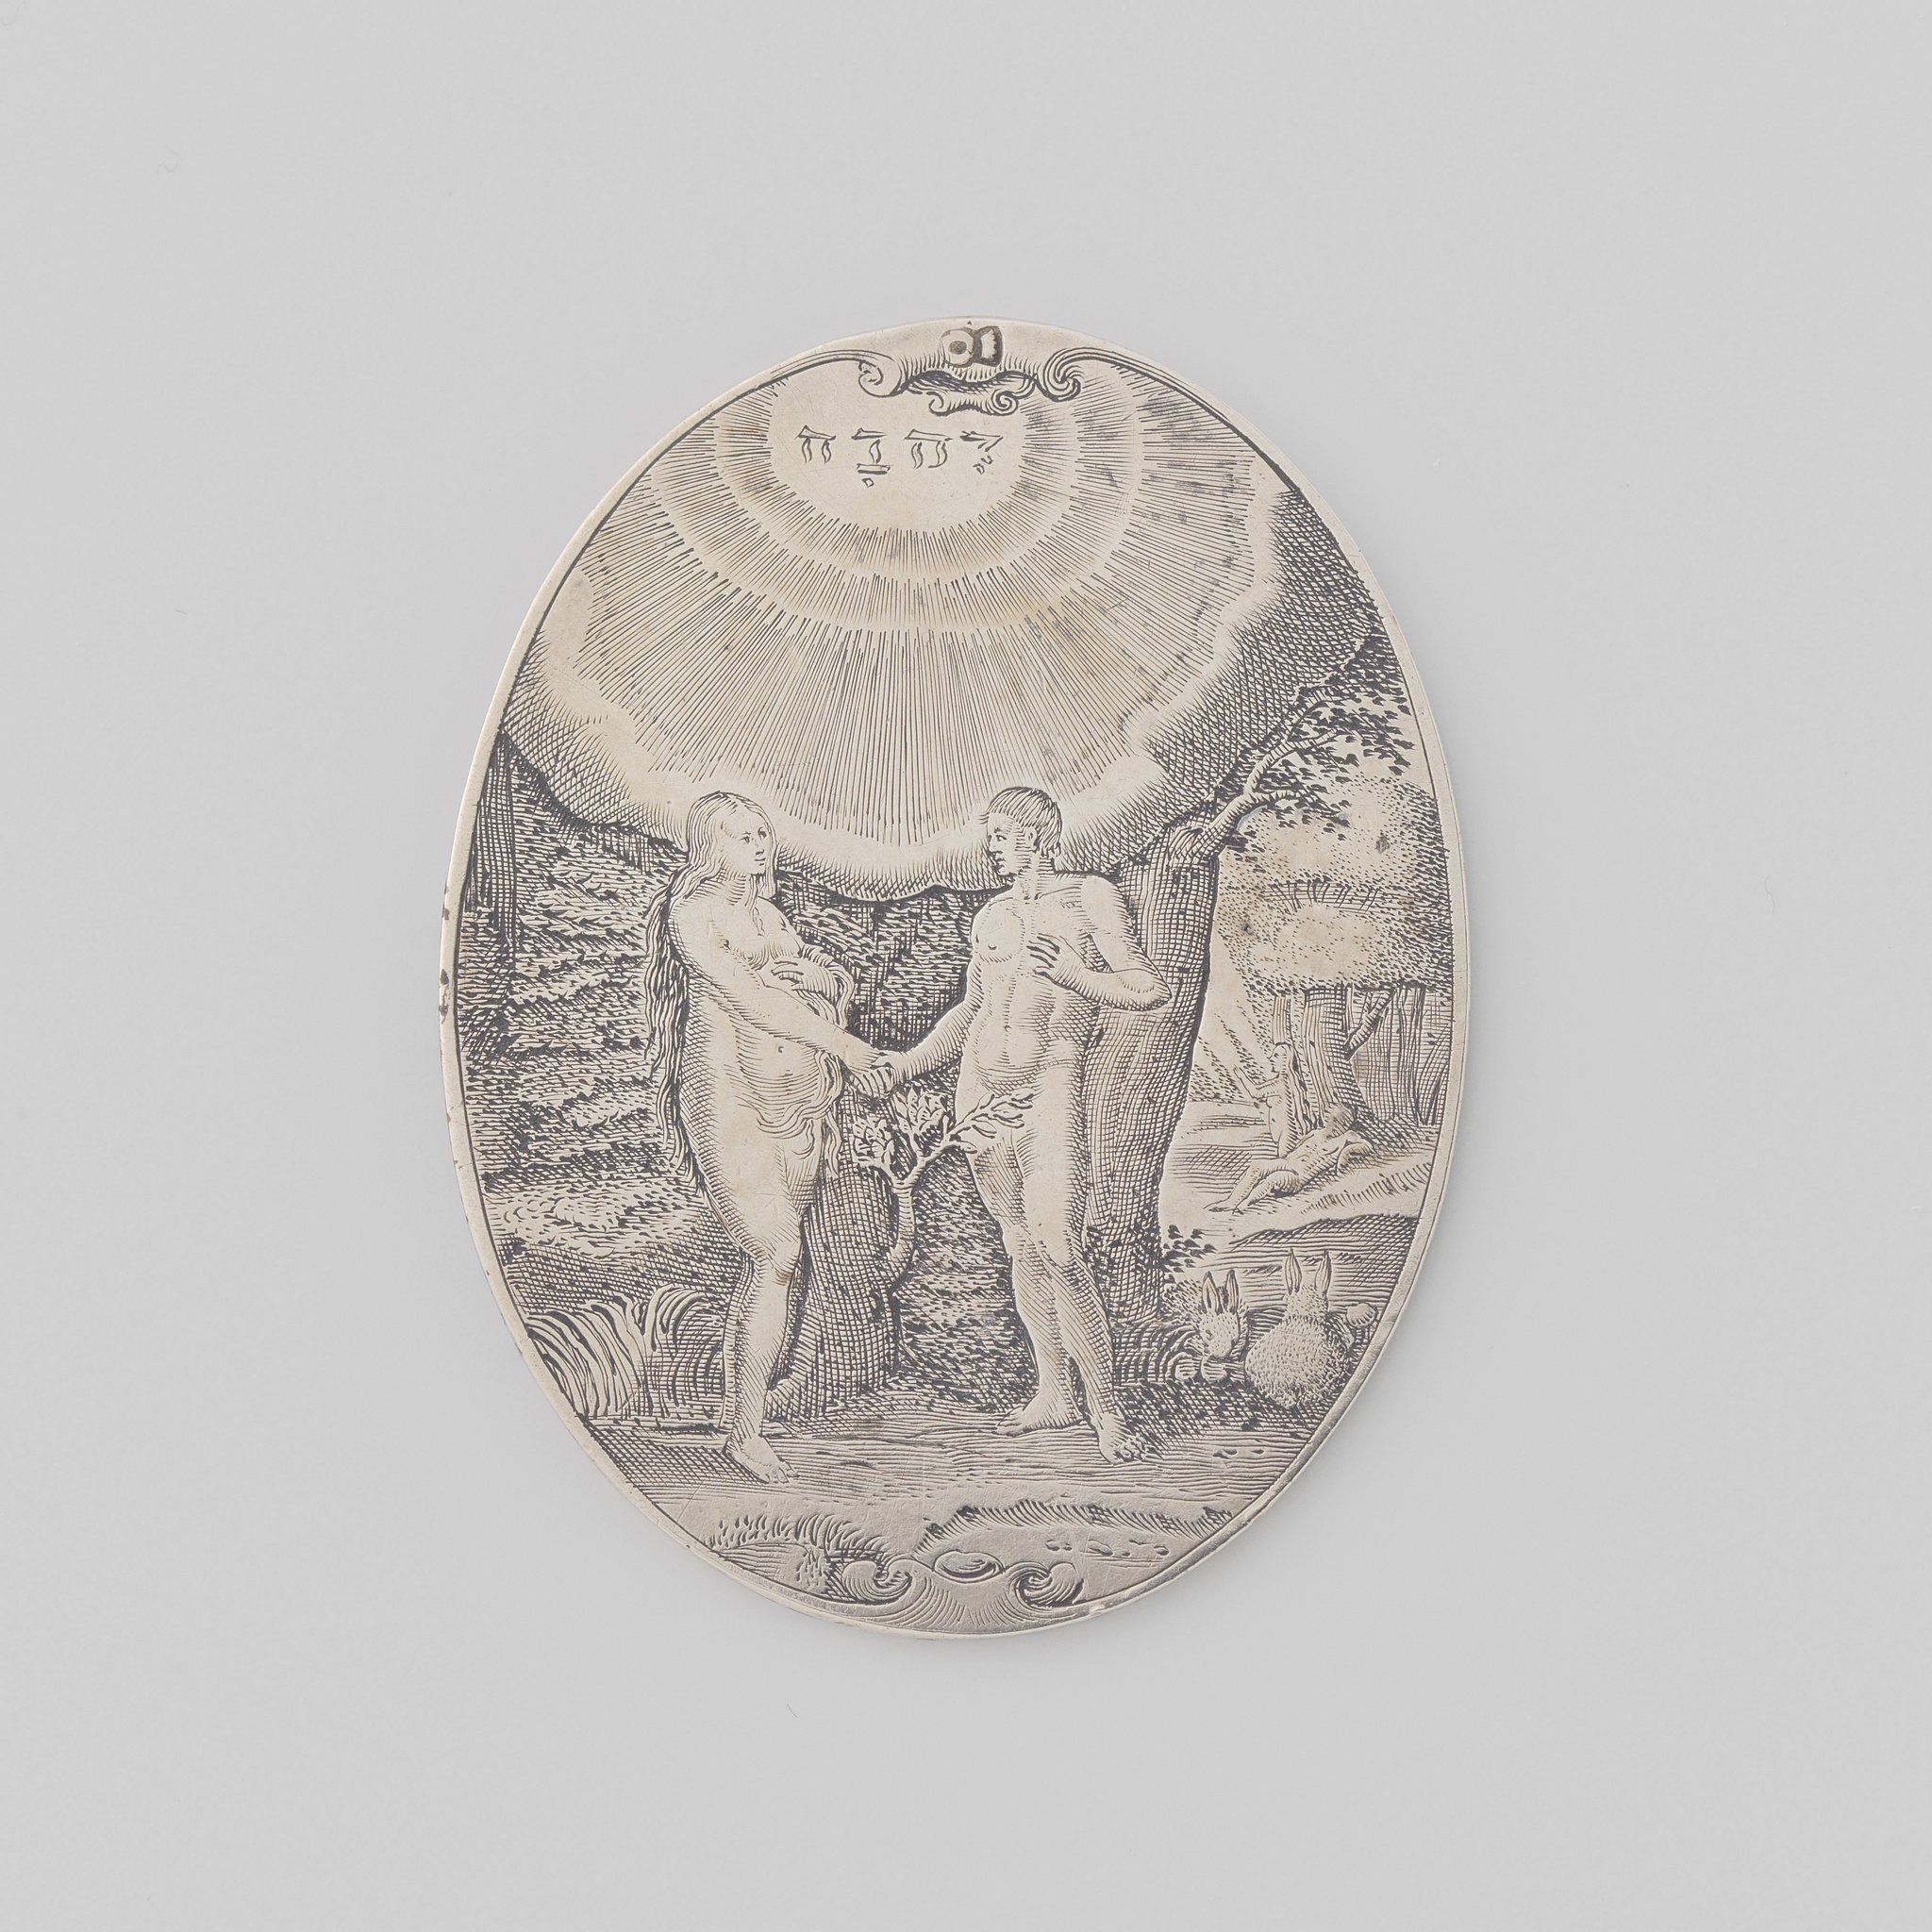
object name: marriage medal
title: Penning met Schepping van Eva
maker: Anonymous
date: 1600-1625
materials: silver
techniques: engraving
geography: netherlands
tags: god brings eve to adam, eve is fashioned from adam's rib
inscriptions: inscription: ‘Den Mensch op Aard / dient nut Gepaard / Sprack Godes Stem / Daarom schiep hij / Een wijt zijn Sij / En gaff se hem’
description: Zilveren ovale penning. Voorzijde: gegraveerde voorstelling van Adam en Eva in het paradijs, zij reiken elkaar de hand. Aan de keerzijde een cartouche versierd met kwabornament en vruchten met het opschrift: DEN MENSCH OP AARD DIENT NIET GEPAARD - SPRAK GODES STEM - DAAROM SCHIEP HIJ - EEN WIJT ZIJN SIJ - EN GAFF SE HEM.